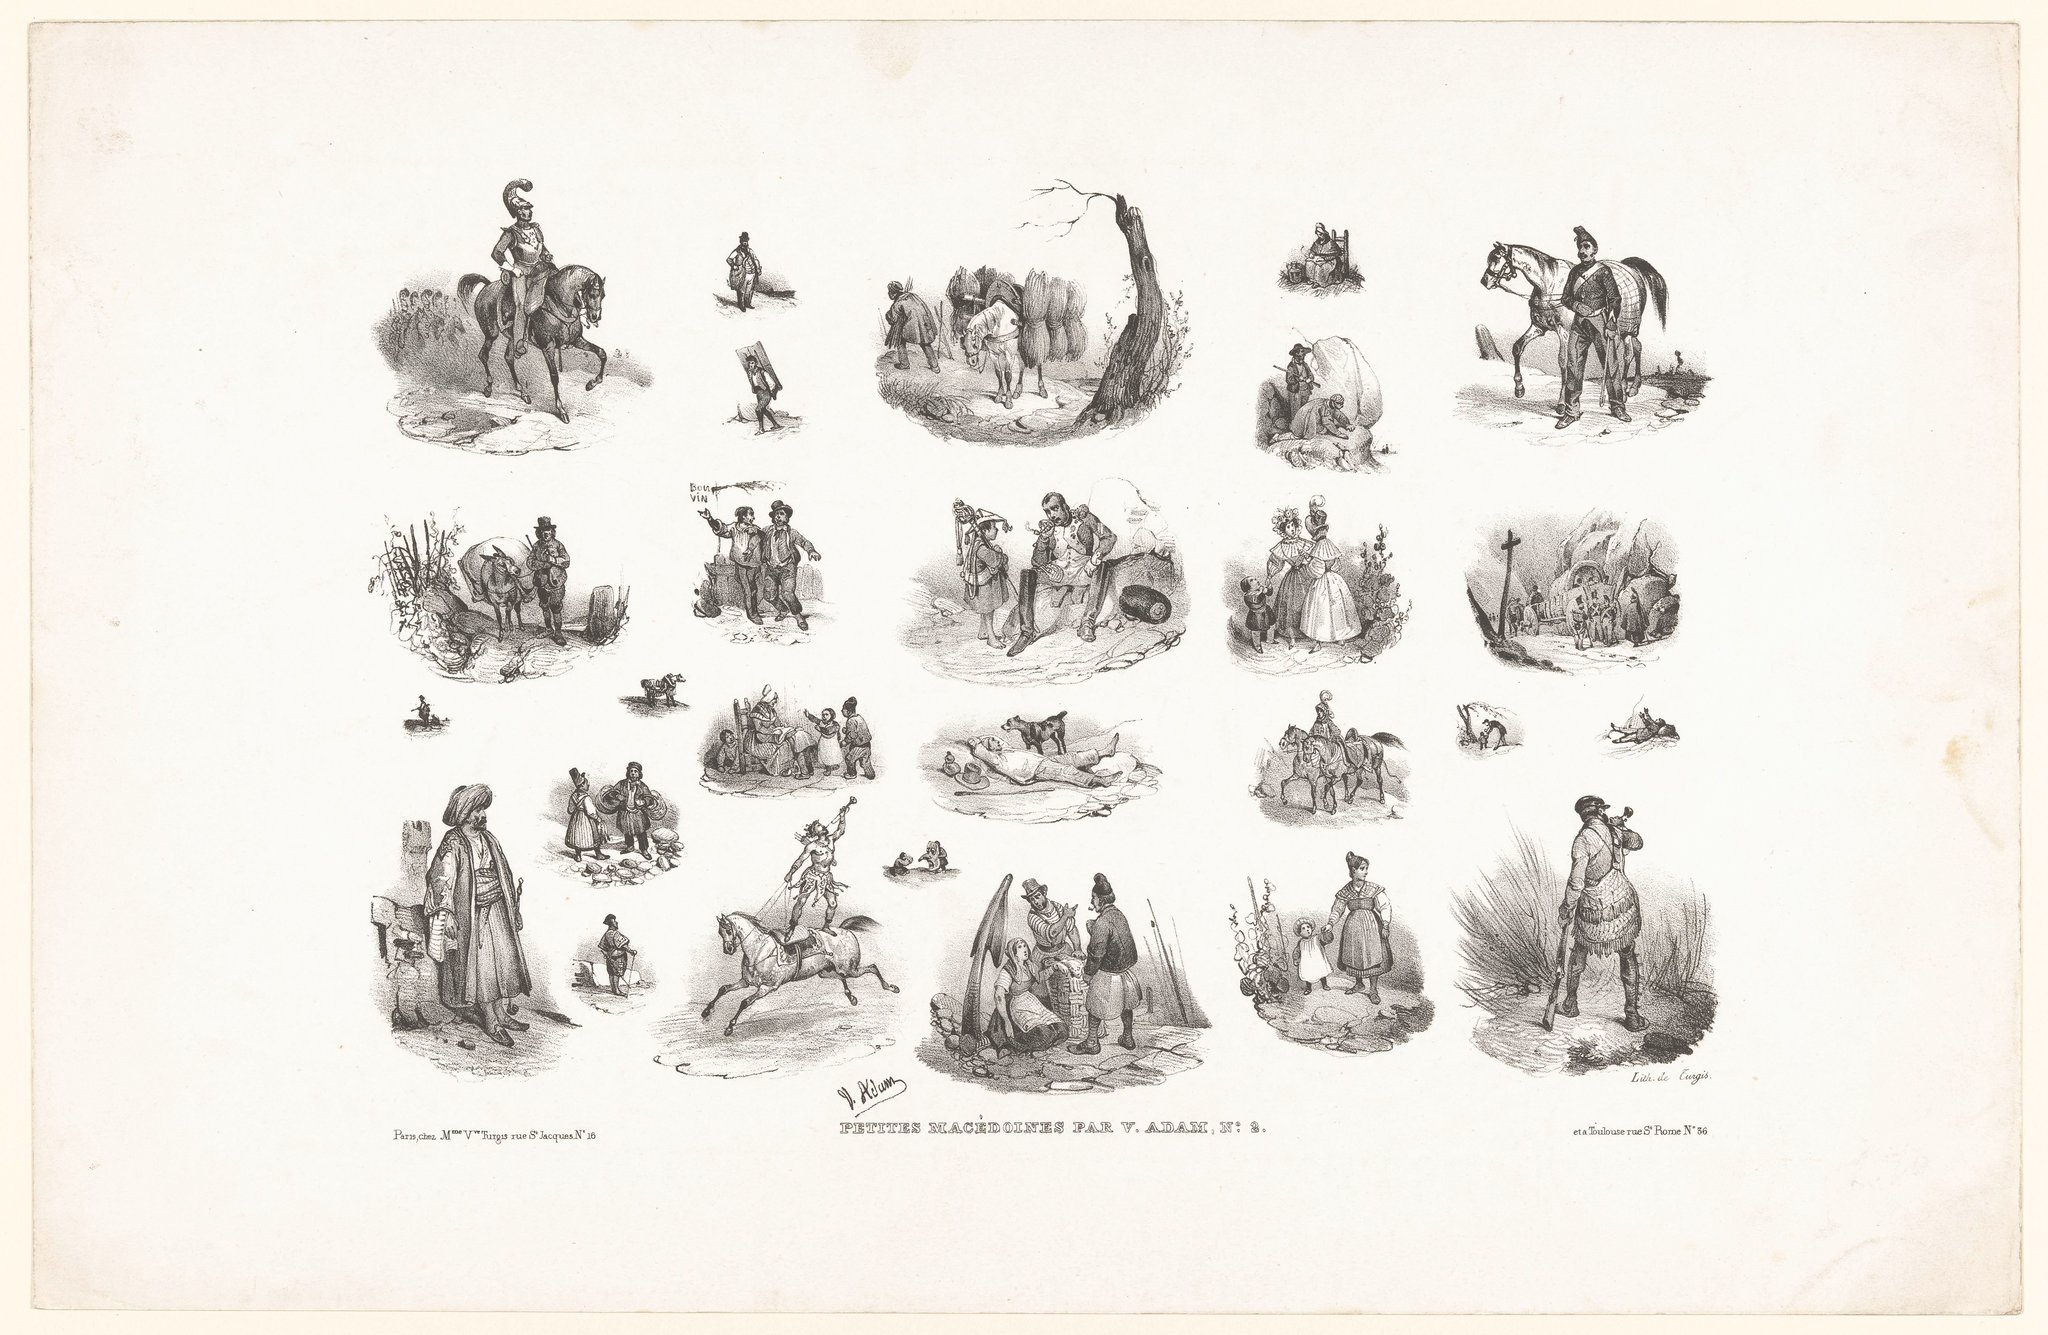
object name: print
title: Diverse schetsen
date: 1842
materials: paper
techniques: lithograph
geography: paris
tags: human types; peoples and nationalities, horse, mule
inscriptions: collector's mark: Lugt 2228